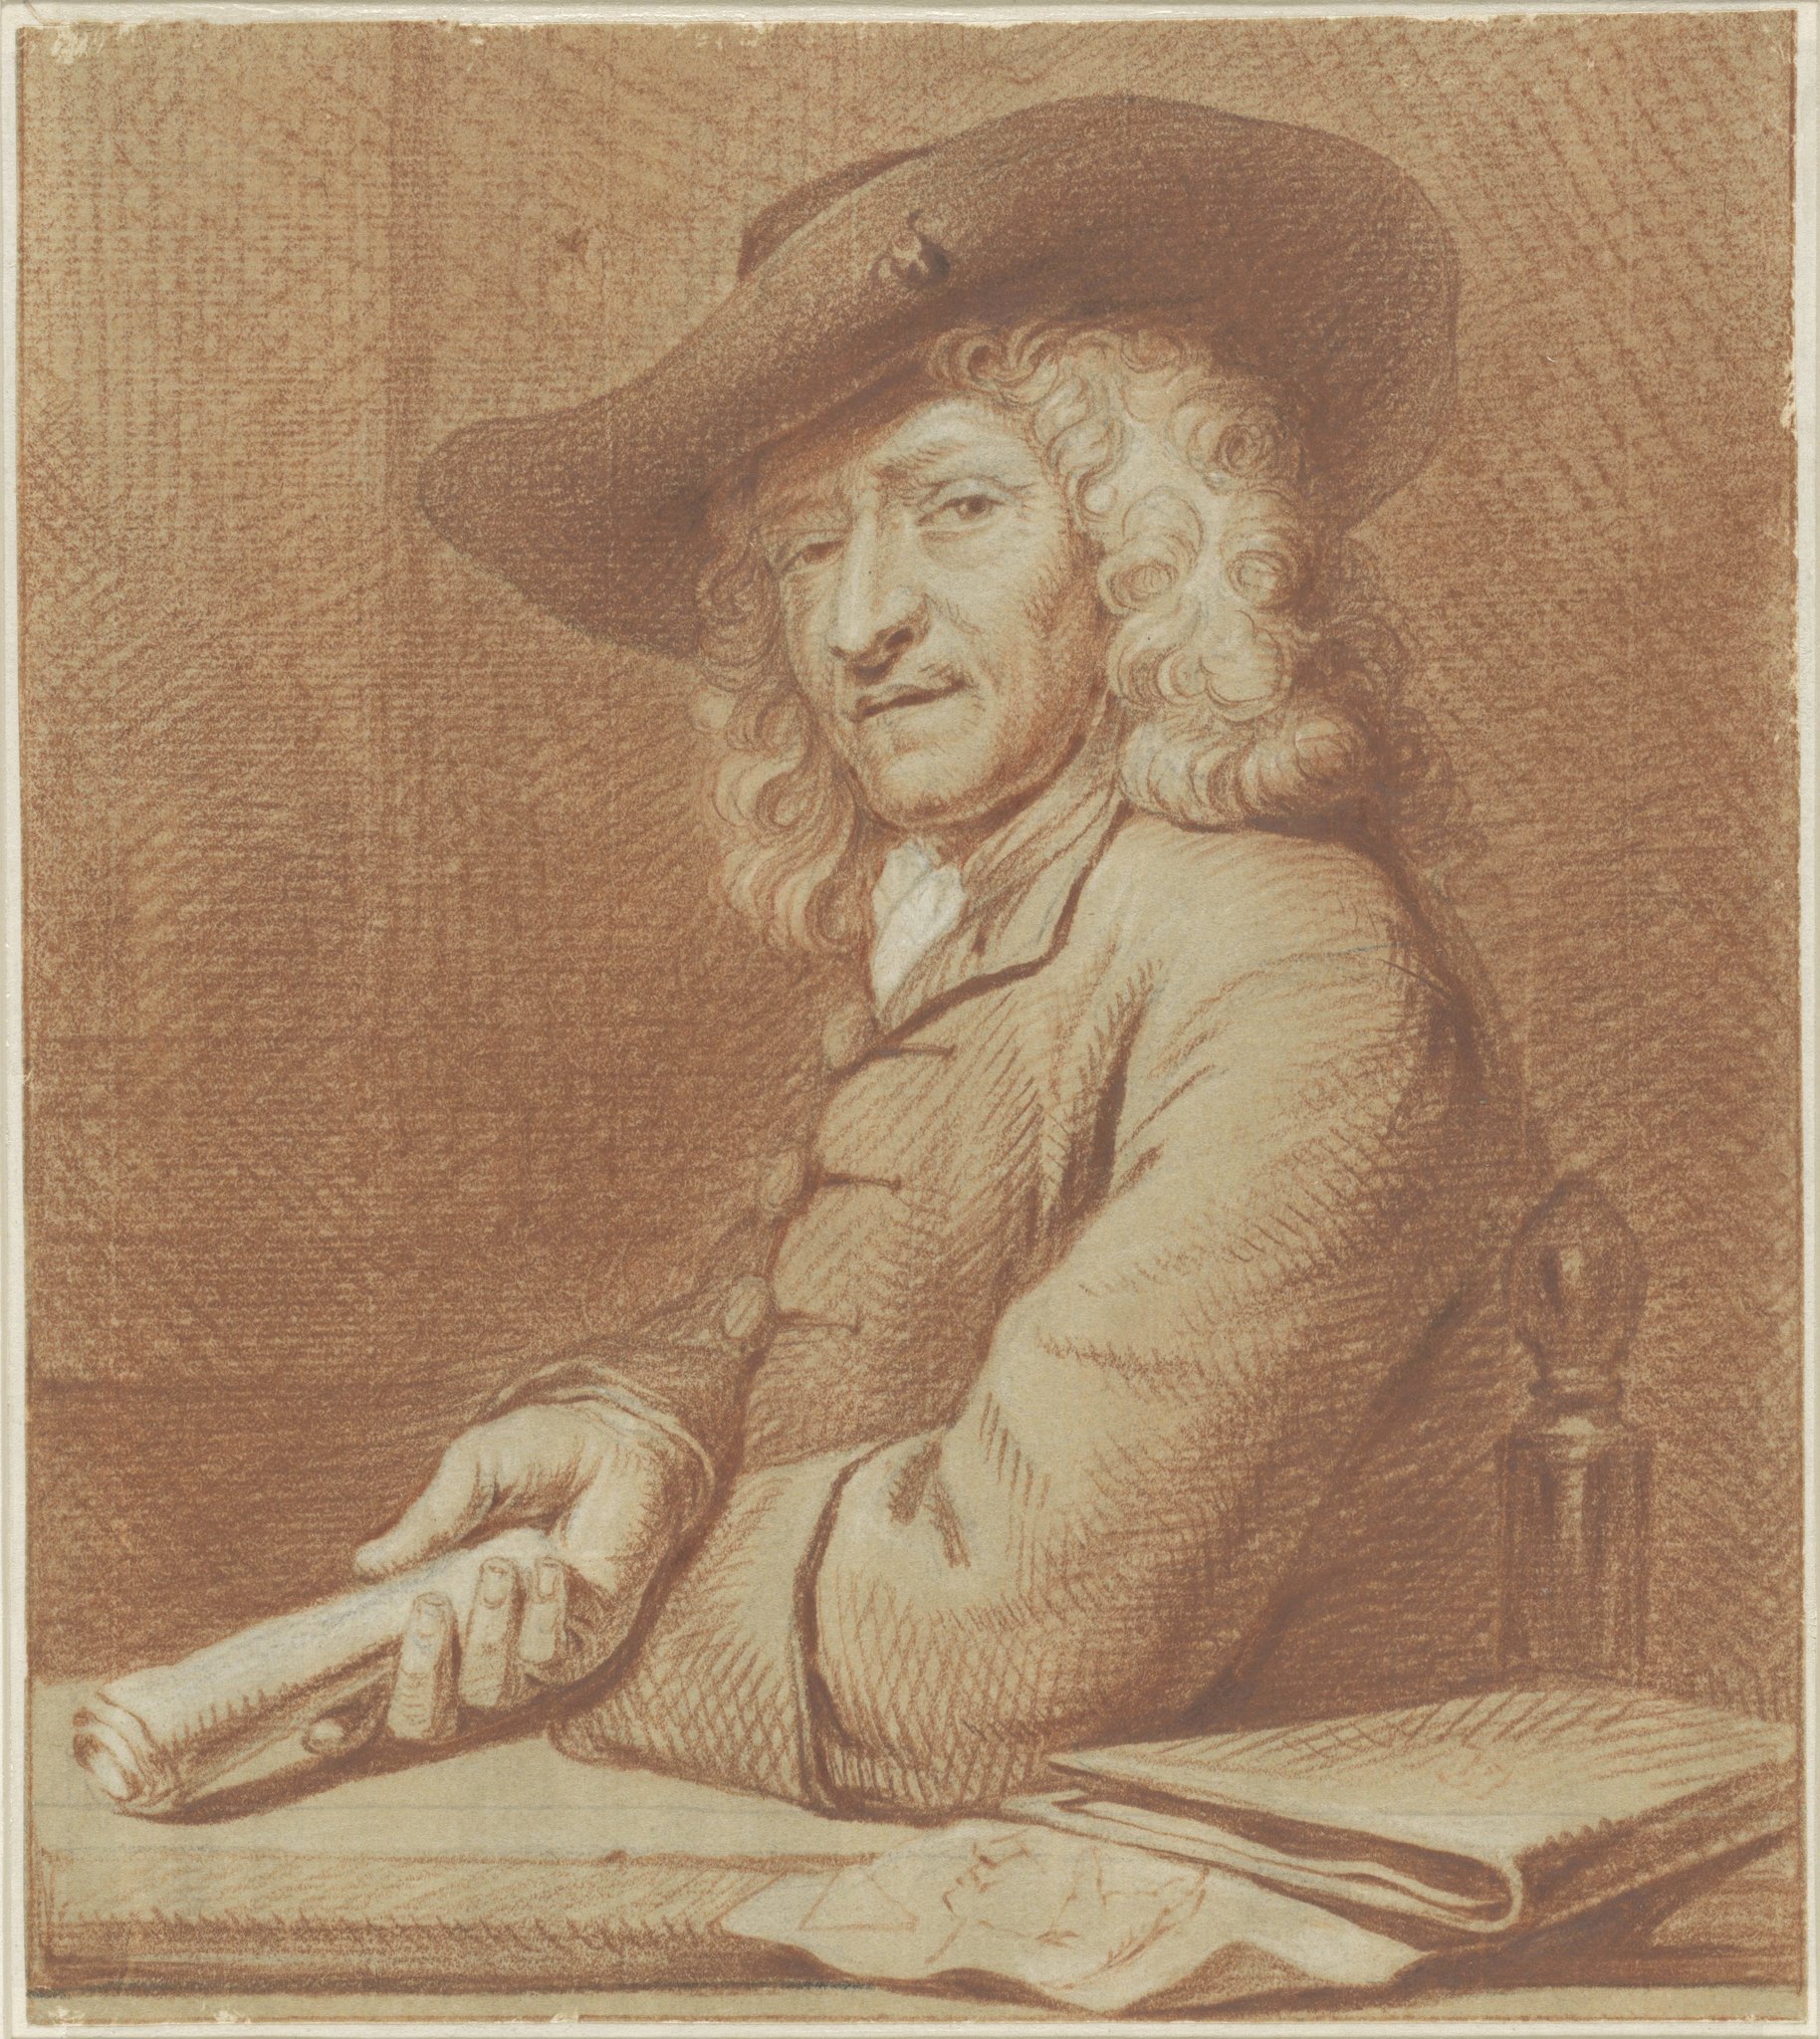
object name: drawing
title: Portret van de tekenaar Jan Pietersz. Zoomer, met hoed en rol papier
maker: norbert van bloemen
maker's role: draughtsman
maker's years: 1670-1746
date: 1680-1746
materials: chalk, paper, pencil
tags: jan pietersz. zomer, historical persons, portrait, self-portrait of artist, portrait, self-portrait of draughtsman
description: Portret van de tekenaar Jan Pietersz. Zoomer, zittend aan tafel met hoed op en rol papier in de hand.